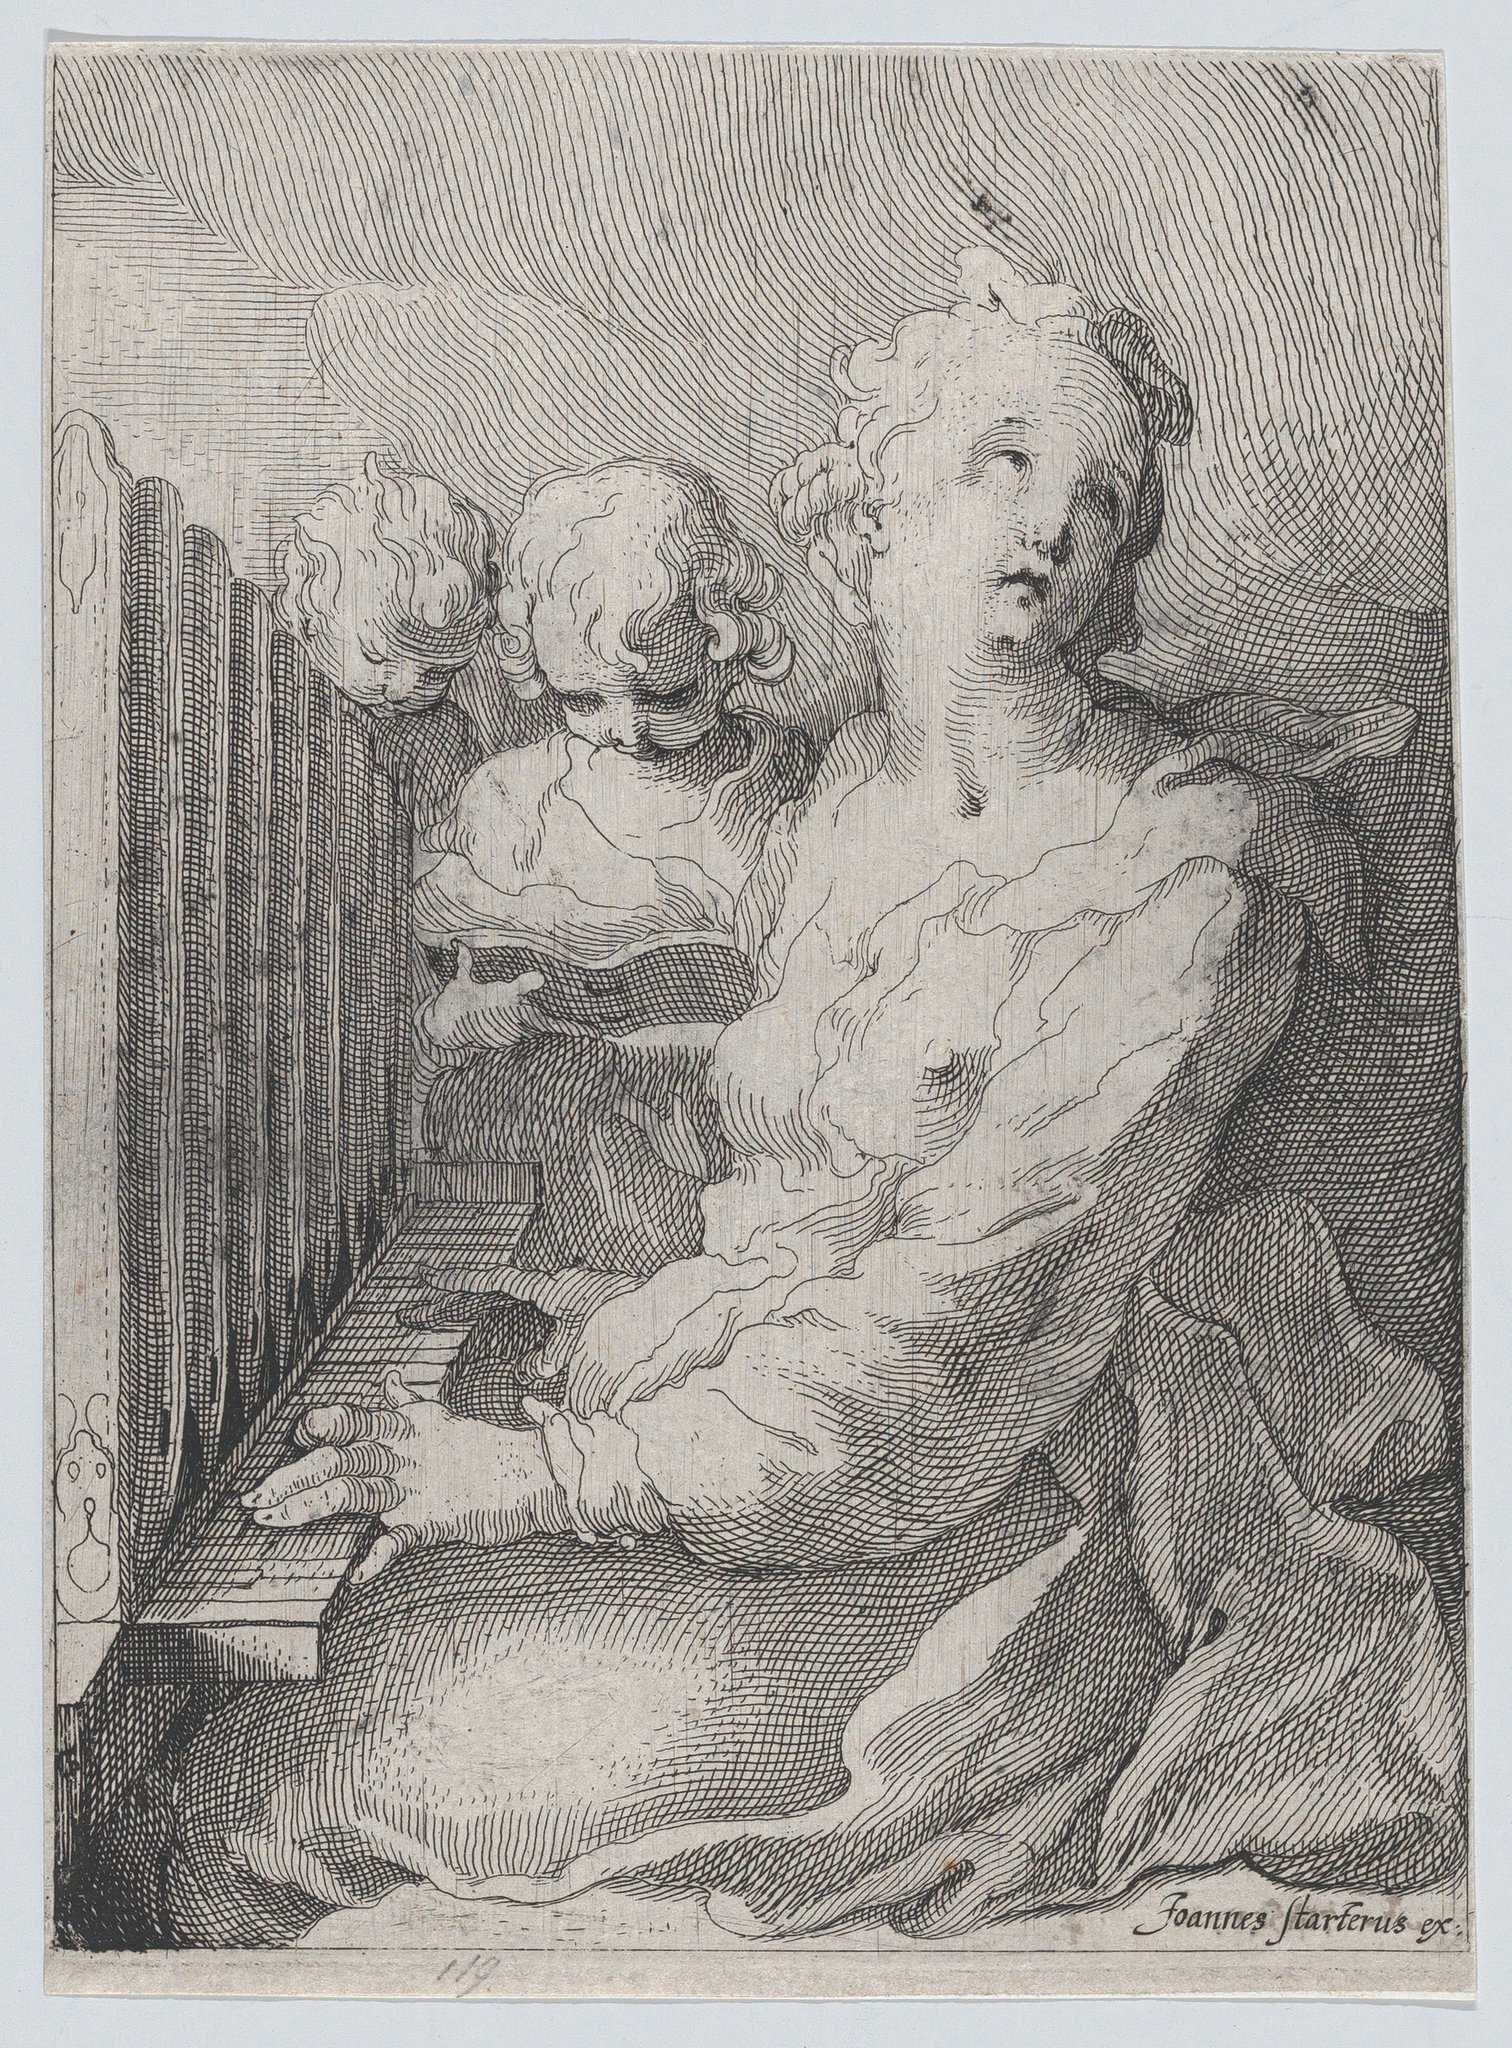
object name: print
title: St. Cecilia, Playing the Organ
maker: gerrit pietersz. sweelink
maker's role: artist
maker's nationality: netherlandish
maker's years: 1566-1612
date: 1593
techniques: etching